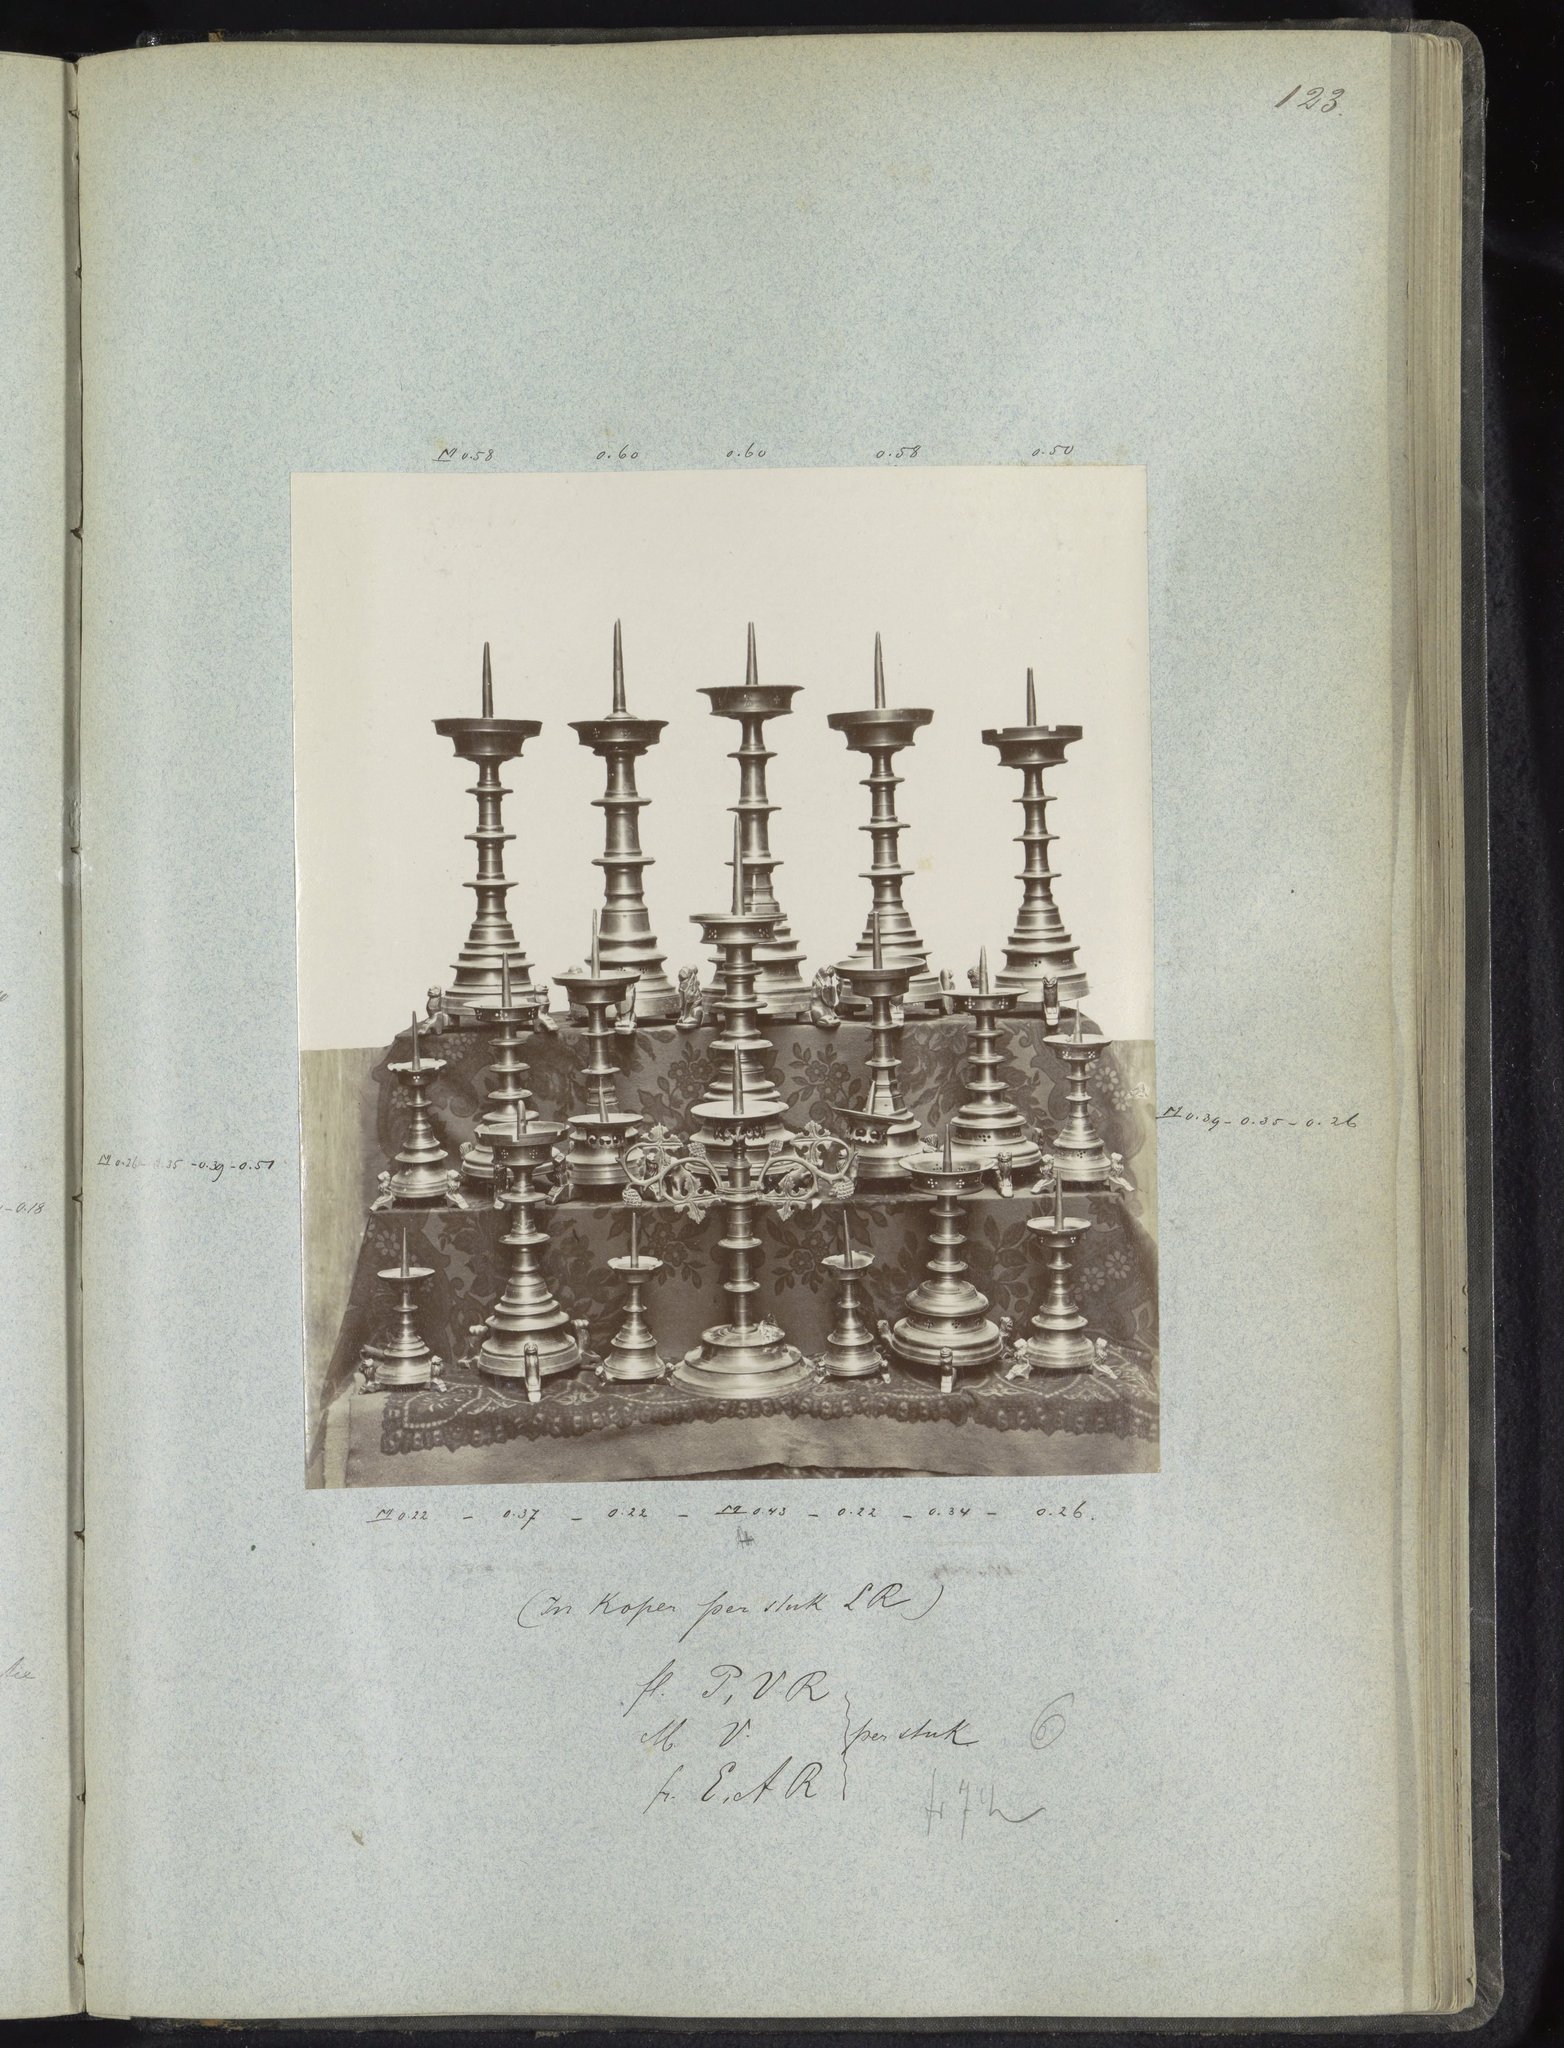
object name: album leaf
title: Negentien koperen kandelaars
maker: Anonymous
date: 1875-1900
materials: paper, photographic support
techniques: albumen print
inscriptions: annotation, annotation